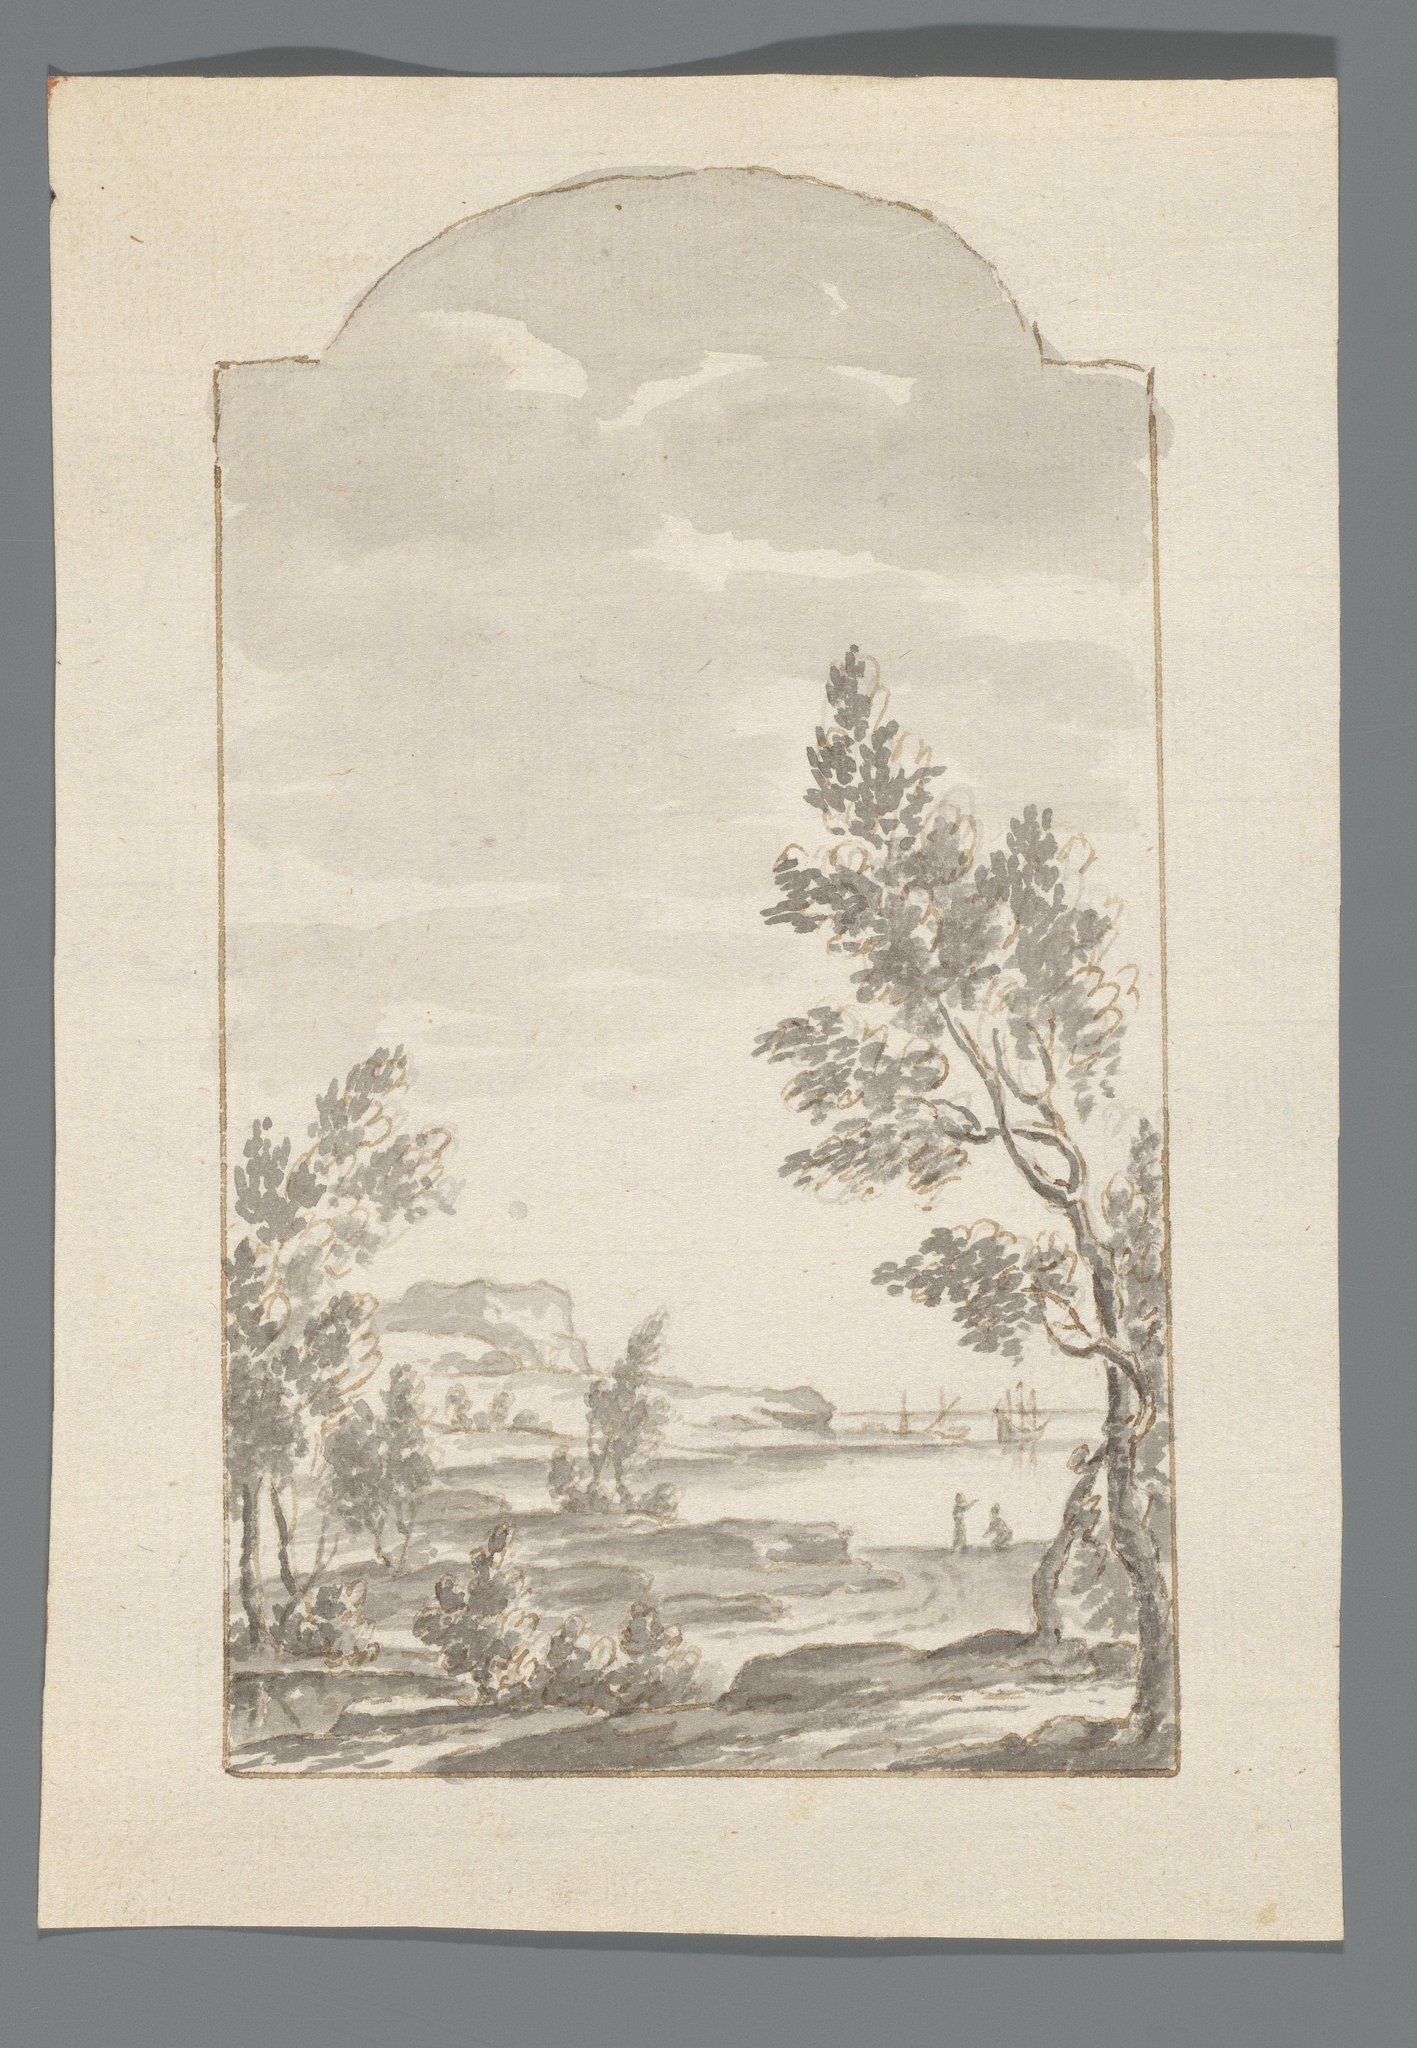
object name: drawing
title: Vergezicht met water en schepen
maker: matthijs balen (1684-1766)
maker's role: draughtsman, painter, print maker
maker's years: 1684-1766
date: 1694-1766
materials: paper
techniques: brush, pen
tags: landscapes with waters, waterscapes, seascapes (in the temperate zone), ships (in general)